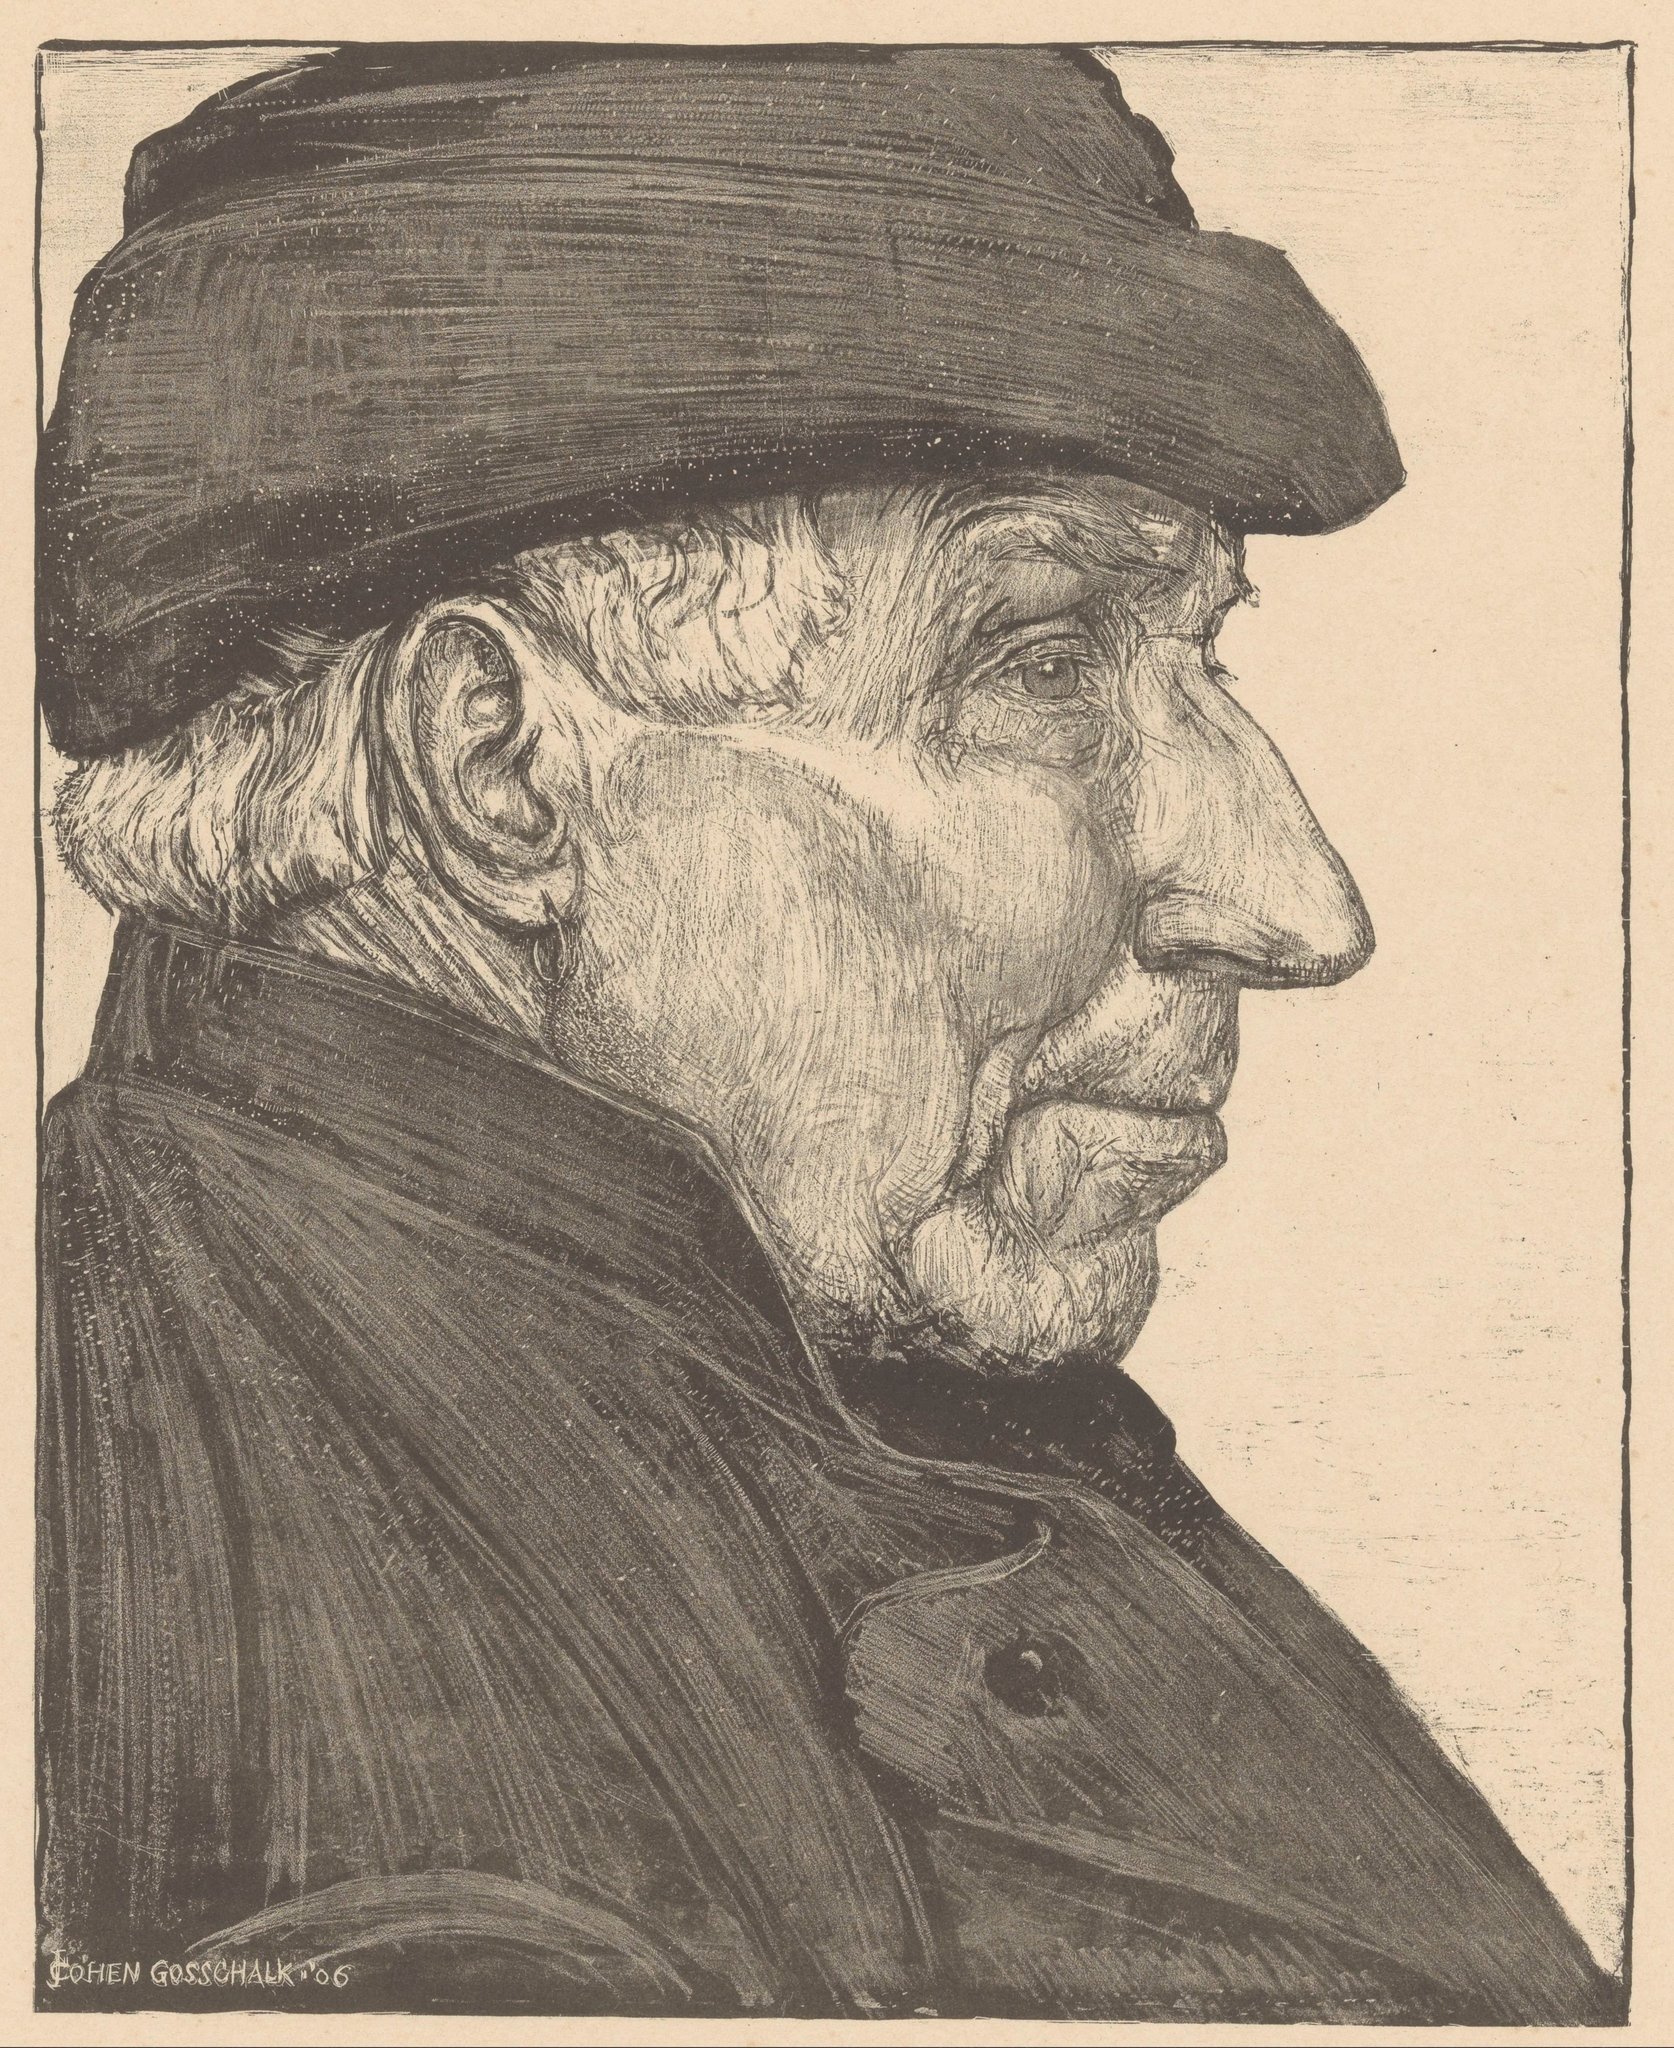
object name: print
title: Portret van een onbekende man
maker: johan henri gustaaf cohen gosschalk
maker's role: draughtsman, print maker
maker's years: 1873-1912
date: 1906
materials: paper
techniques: lithograph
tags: anonymous historical person portrayed alone, head-gear: cap, ear-rings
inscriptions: collector's mark: Lugt 2228, collector's mark: Lugt 2760